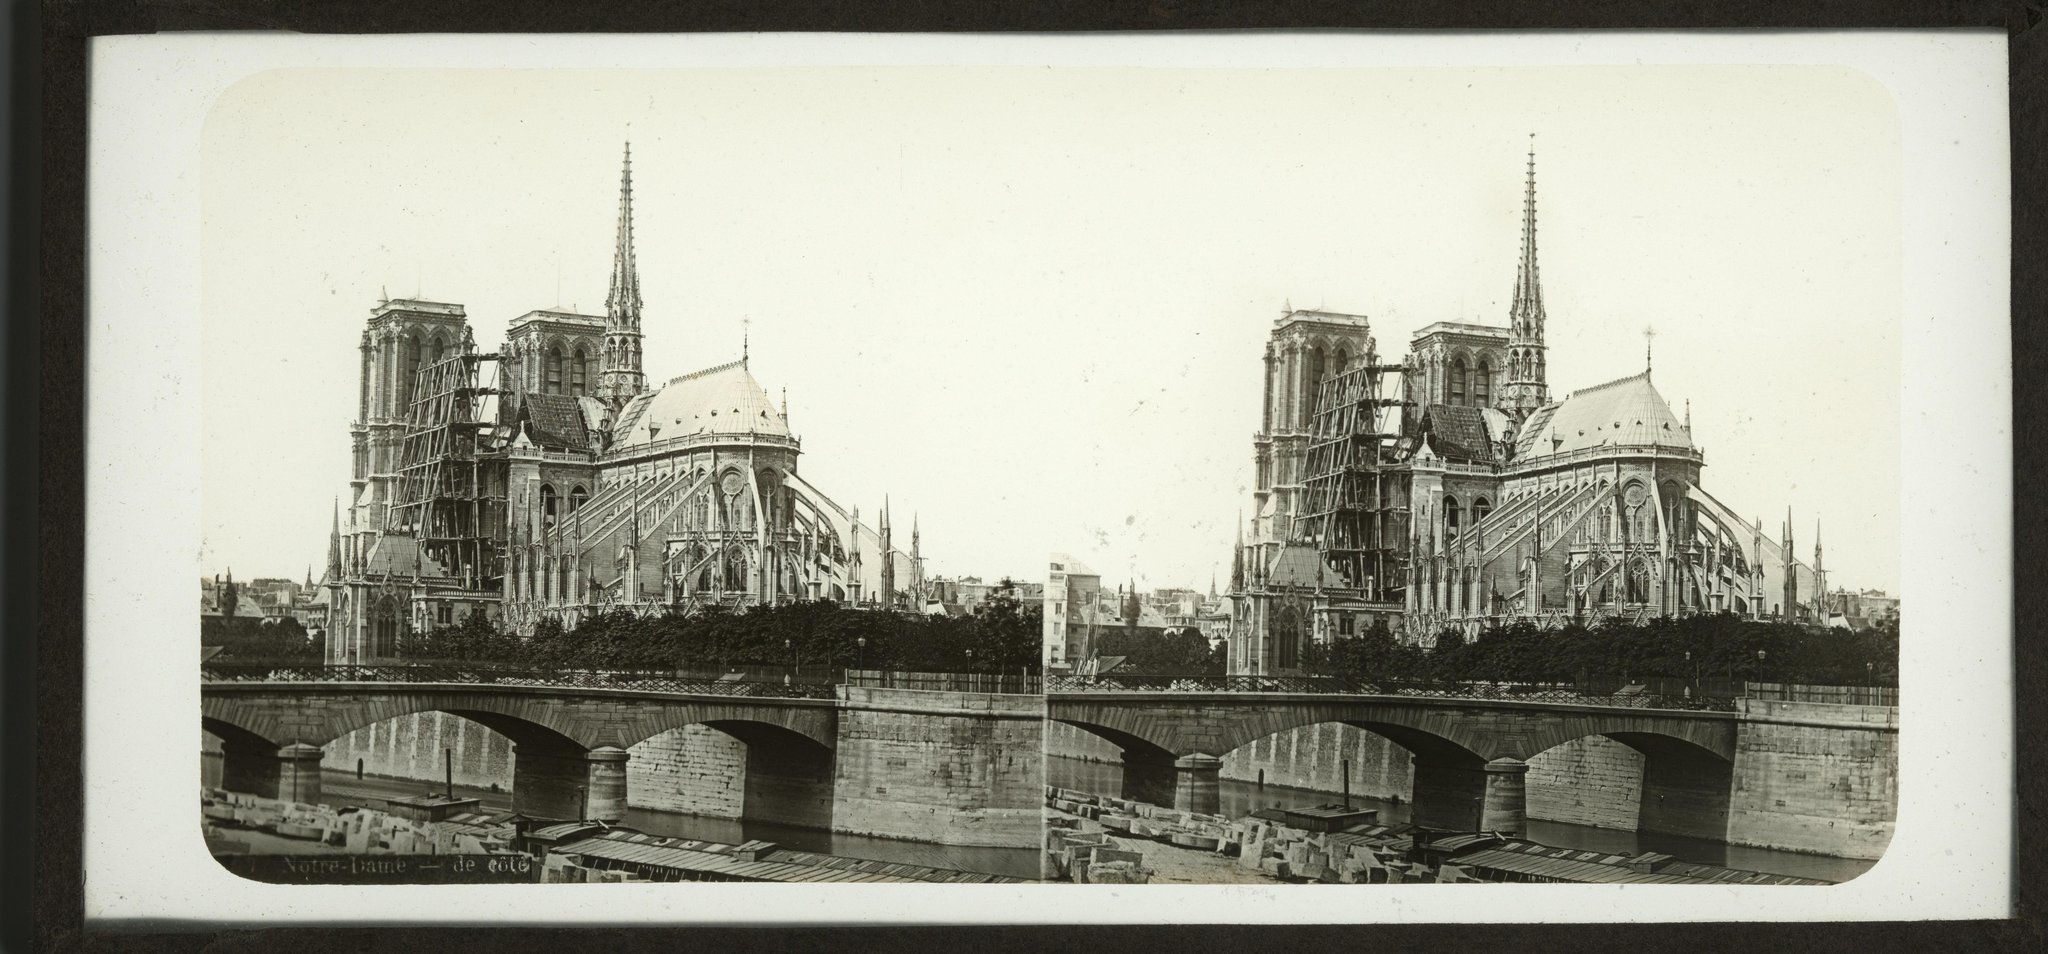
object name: photograph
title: Notre-Dame de côté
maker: Anonymous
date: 1855-1865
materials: glass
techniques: photography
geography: paris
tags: church (exterior)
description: Gezicht op de achterzijde van de Notre Dame in Parijs.